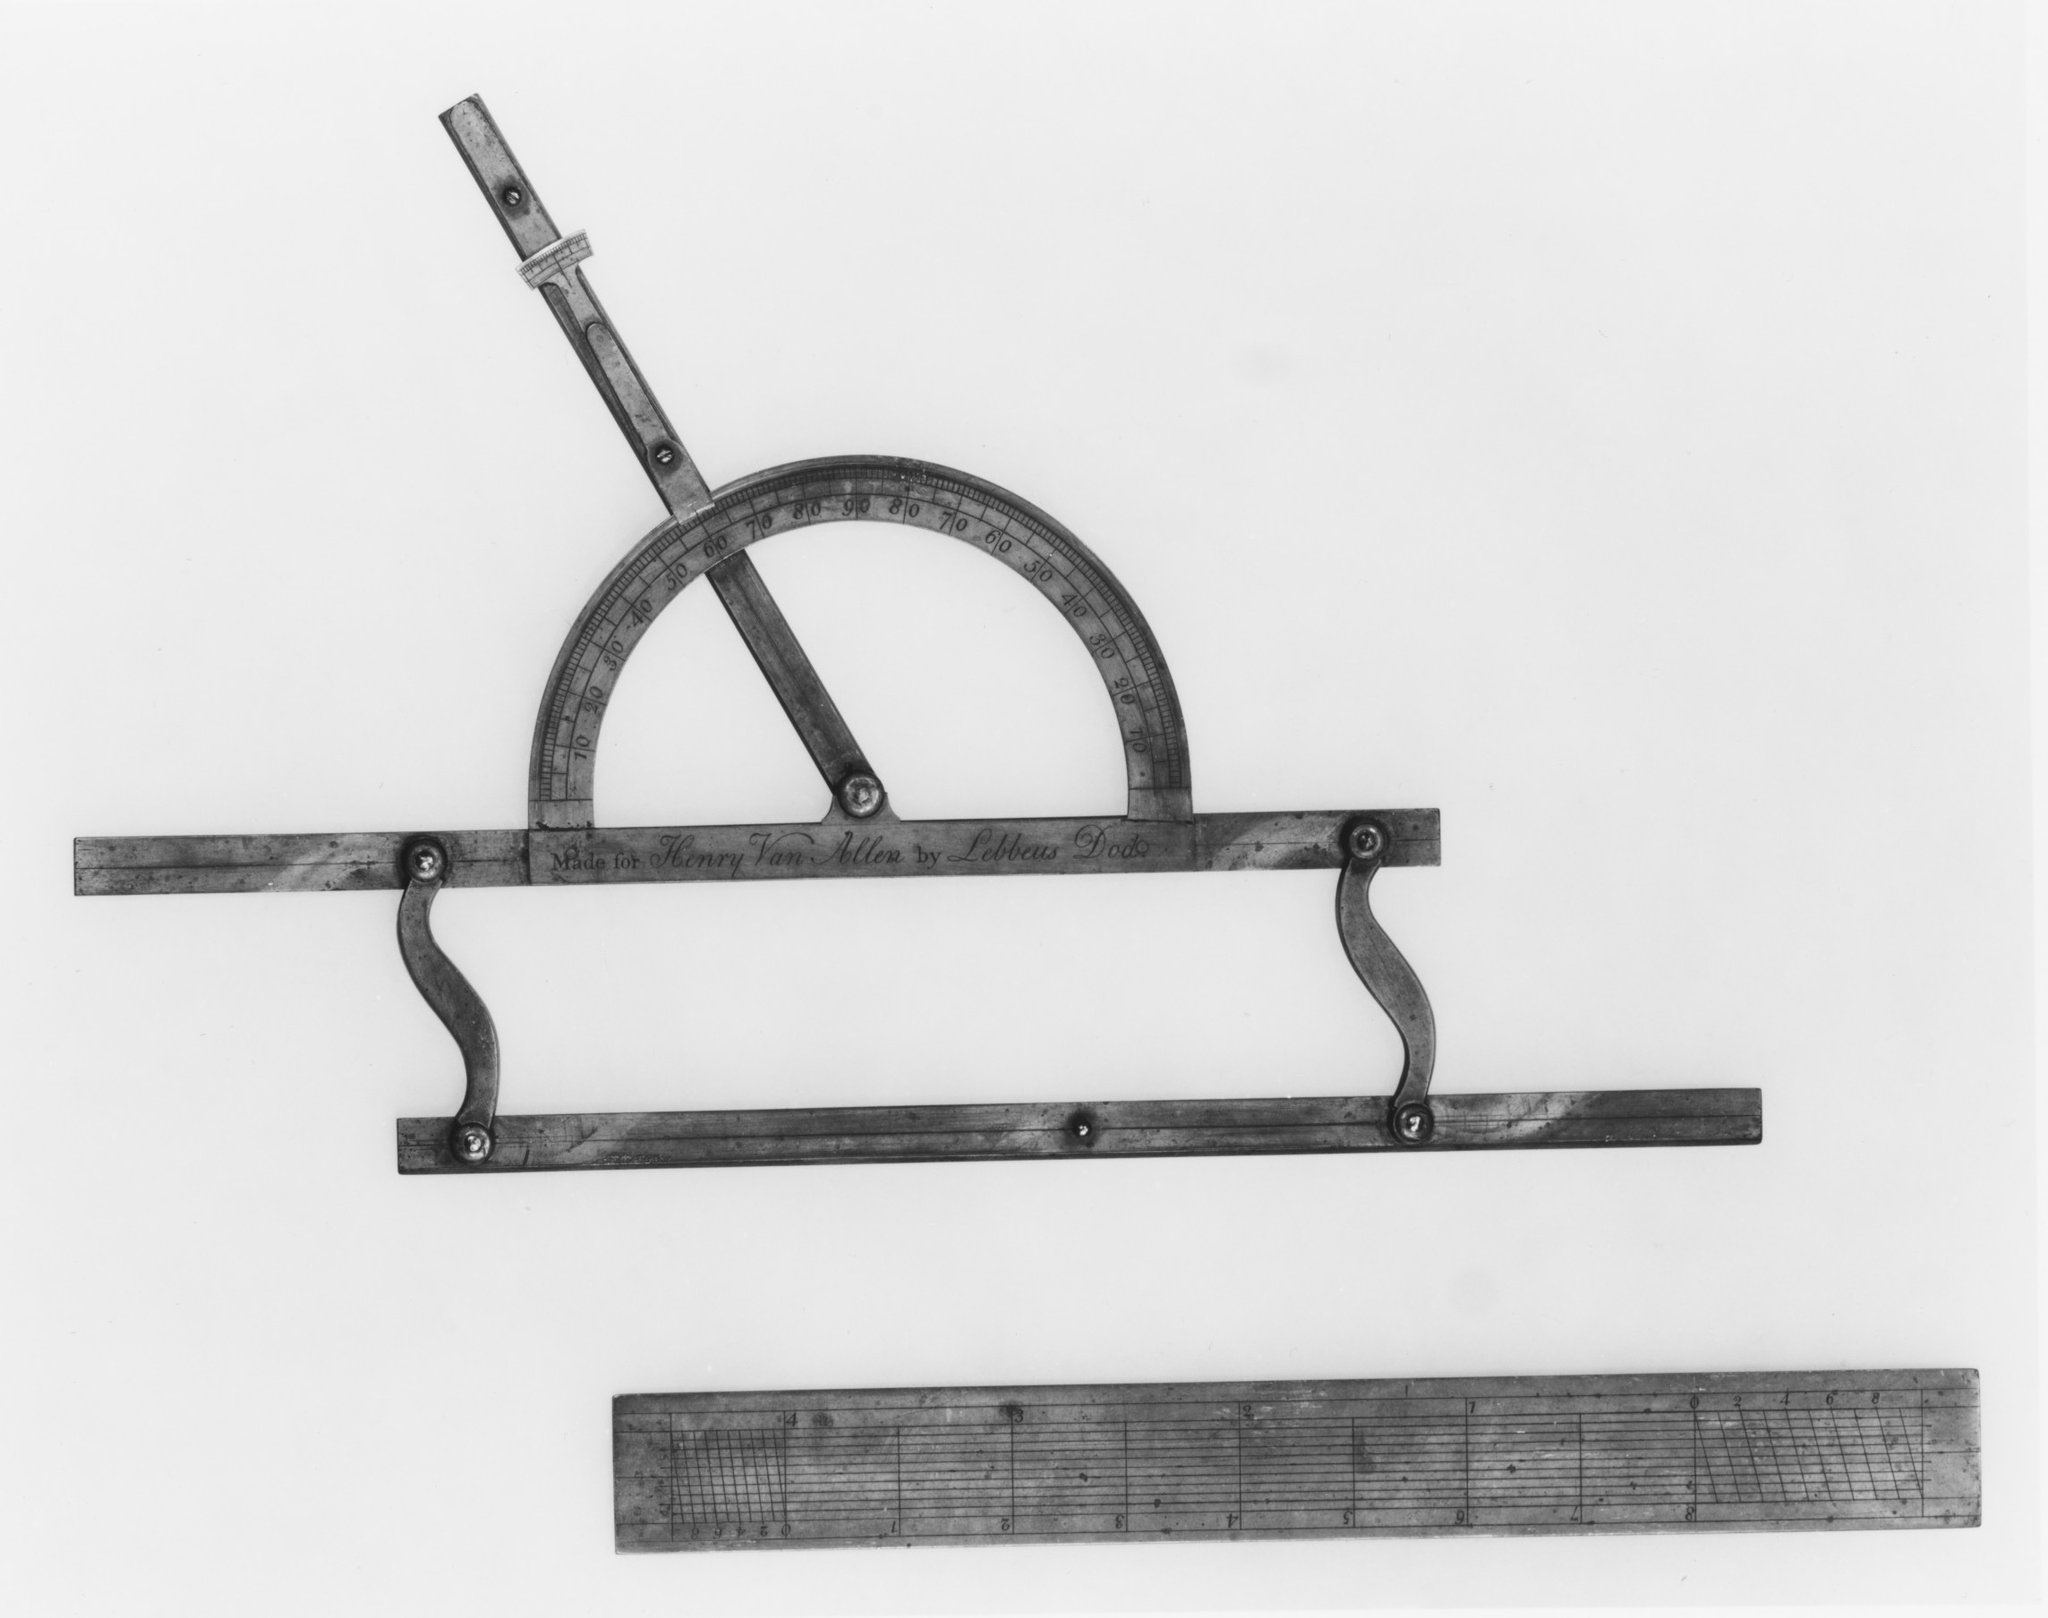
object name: parallel rule with protractor and plotting scale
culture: american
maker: lebbeus dod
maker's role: maker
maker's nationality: american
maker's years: 1739-1816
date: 1796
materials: brass, wood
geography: united states